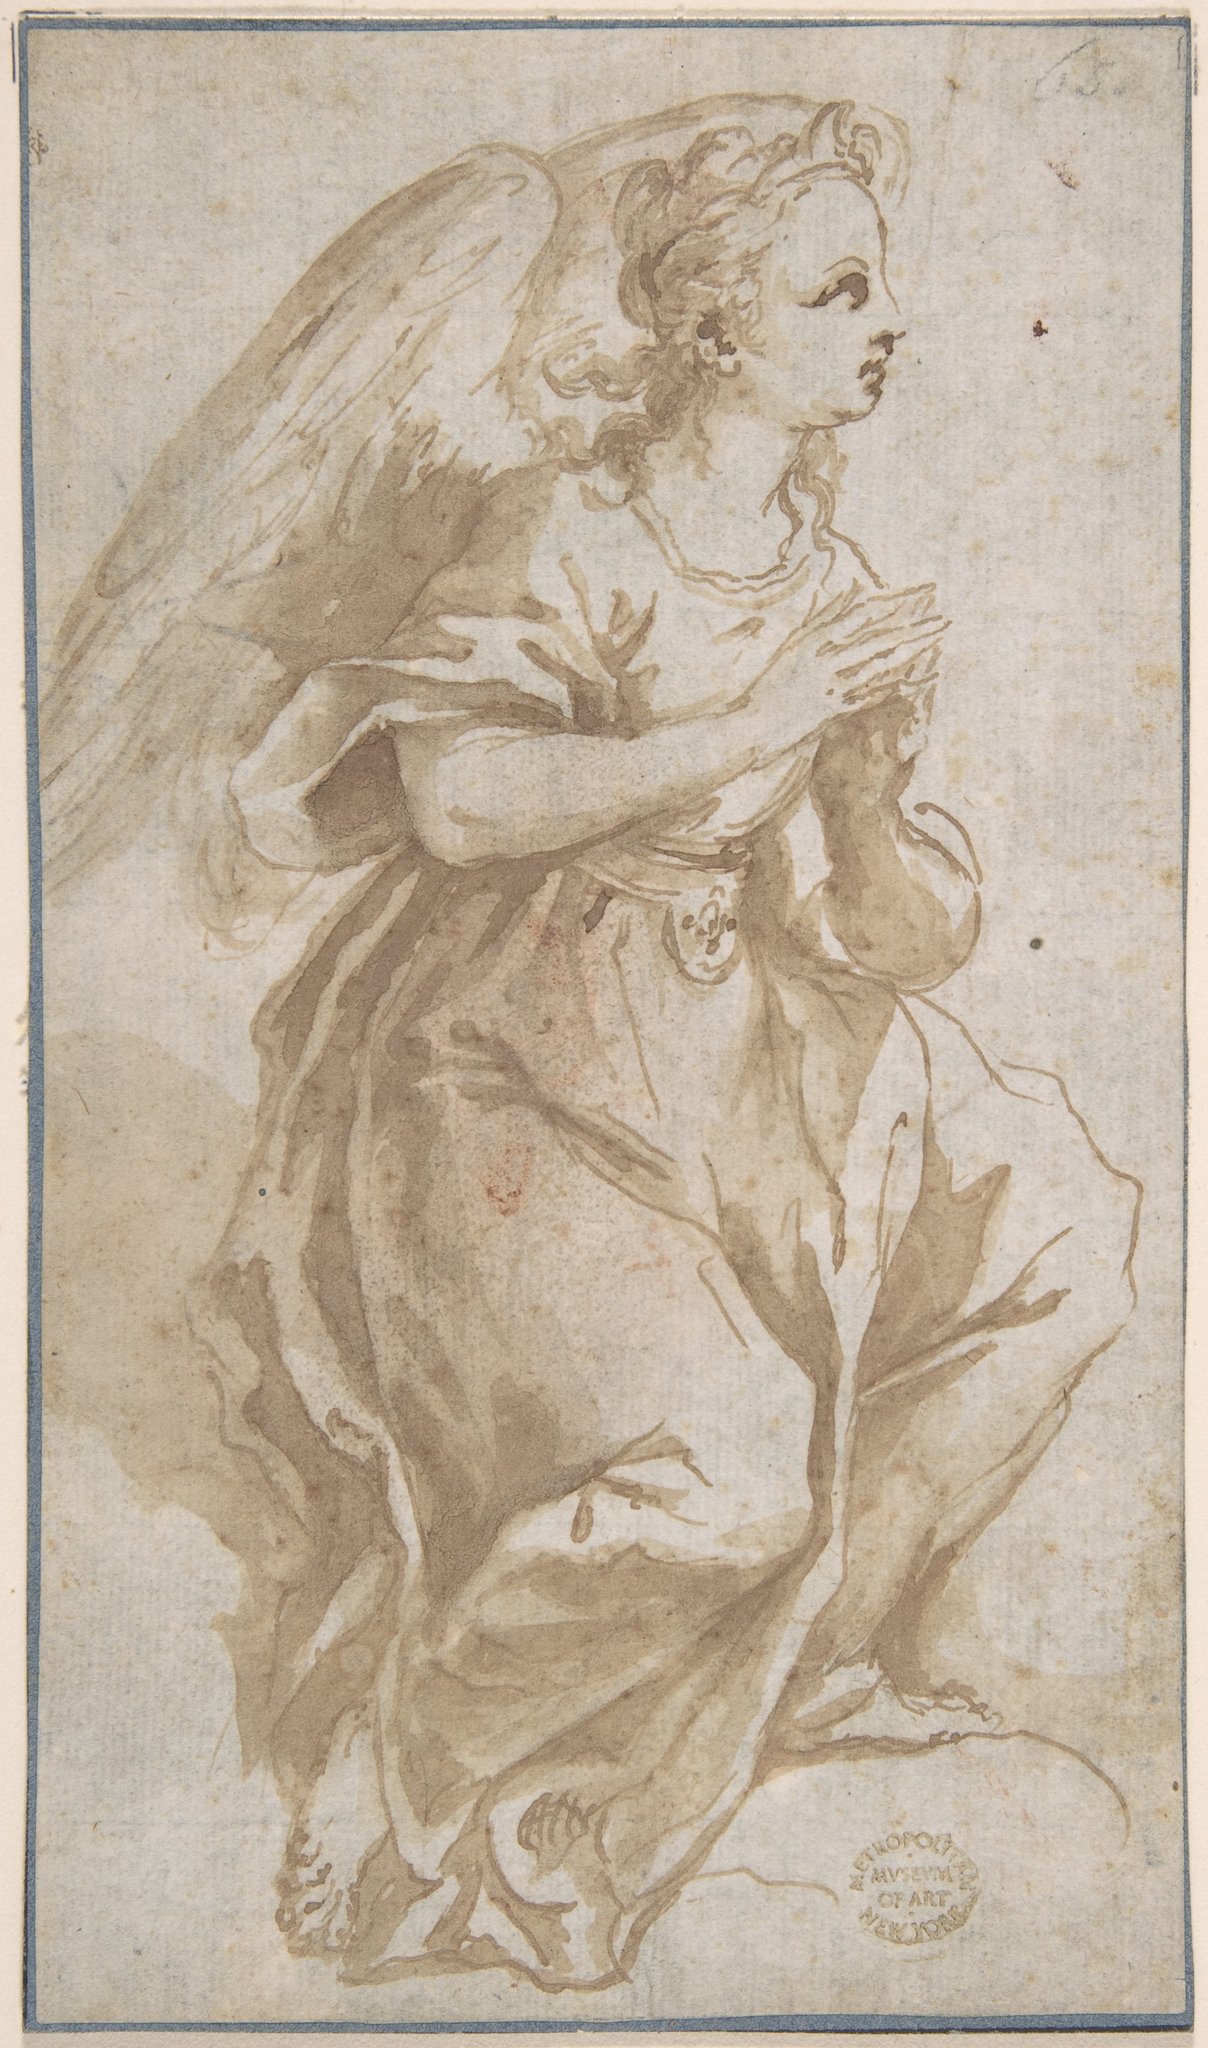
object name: drawing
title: An Angel in Adoration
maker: anonymous, italian, roman-bolognese, 17th century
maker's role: artist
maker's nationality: italian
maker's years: 1600-1700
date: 1601-1700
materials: ink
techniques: brush, pen, wash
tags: angels